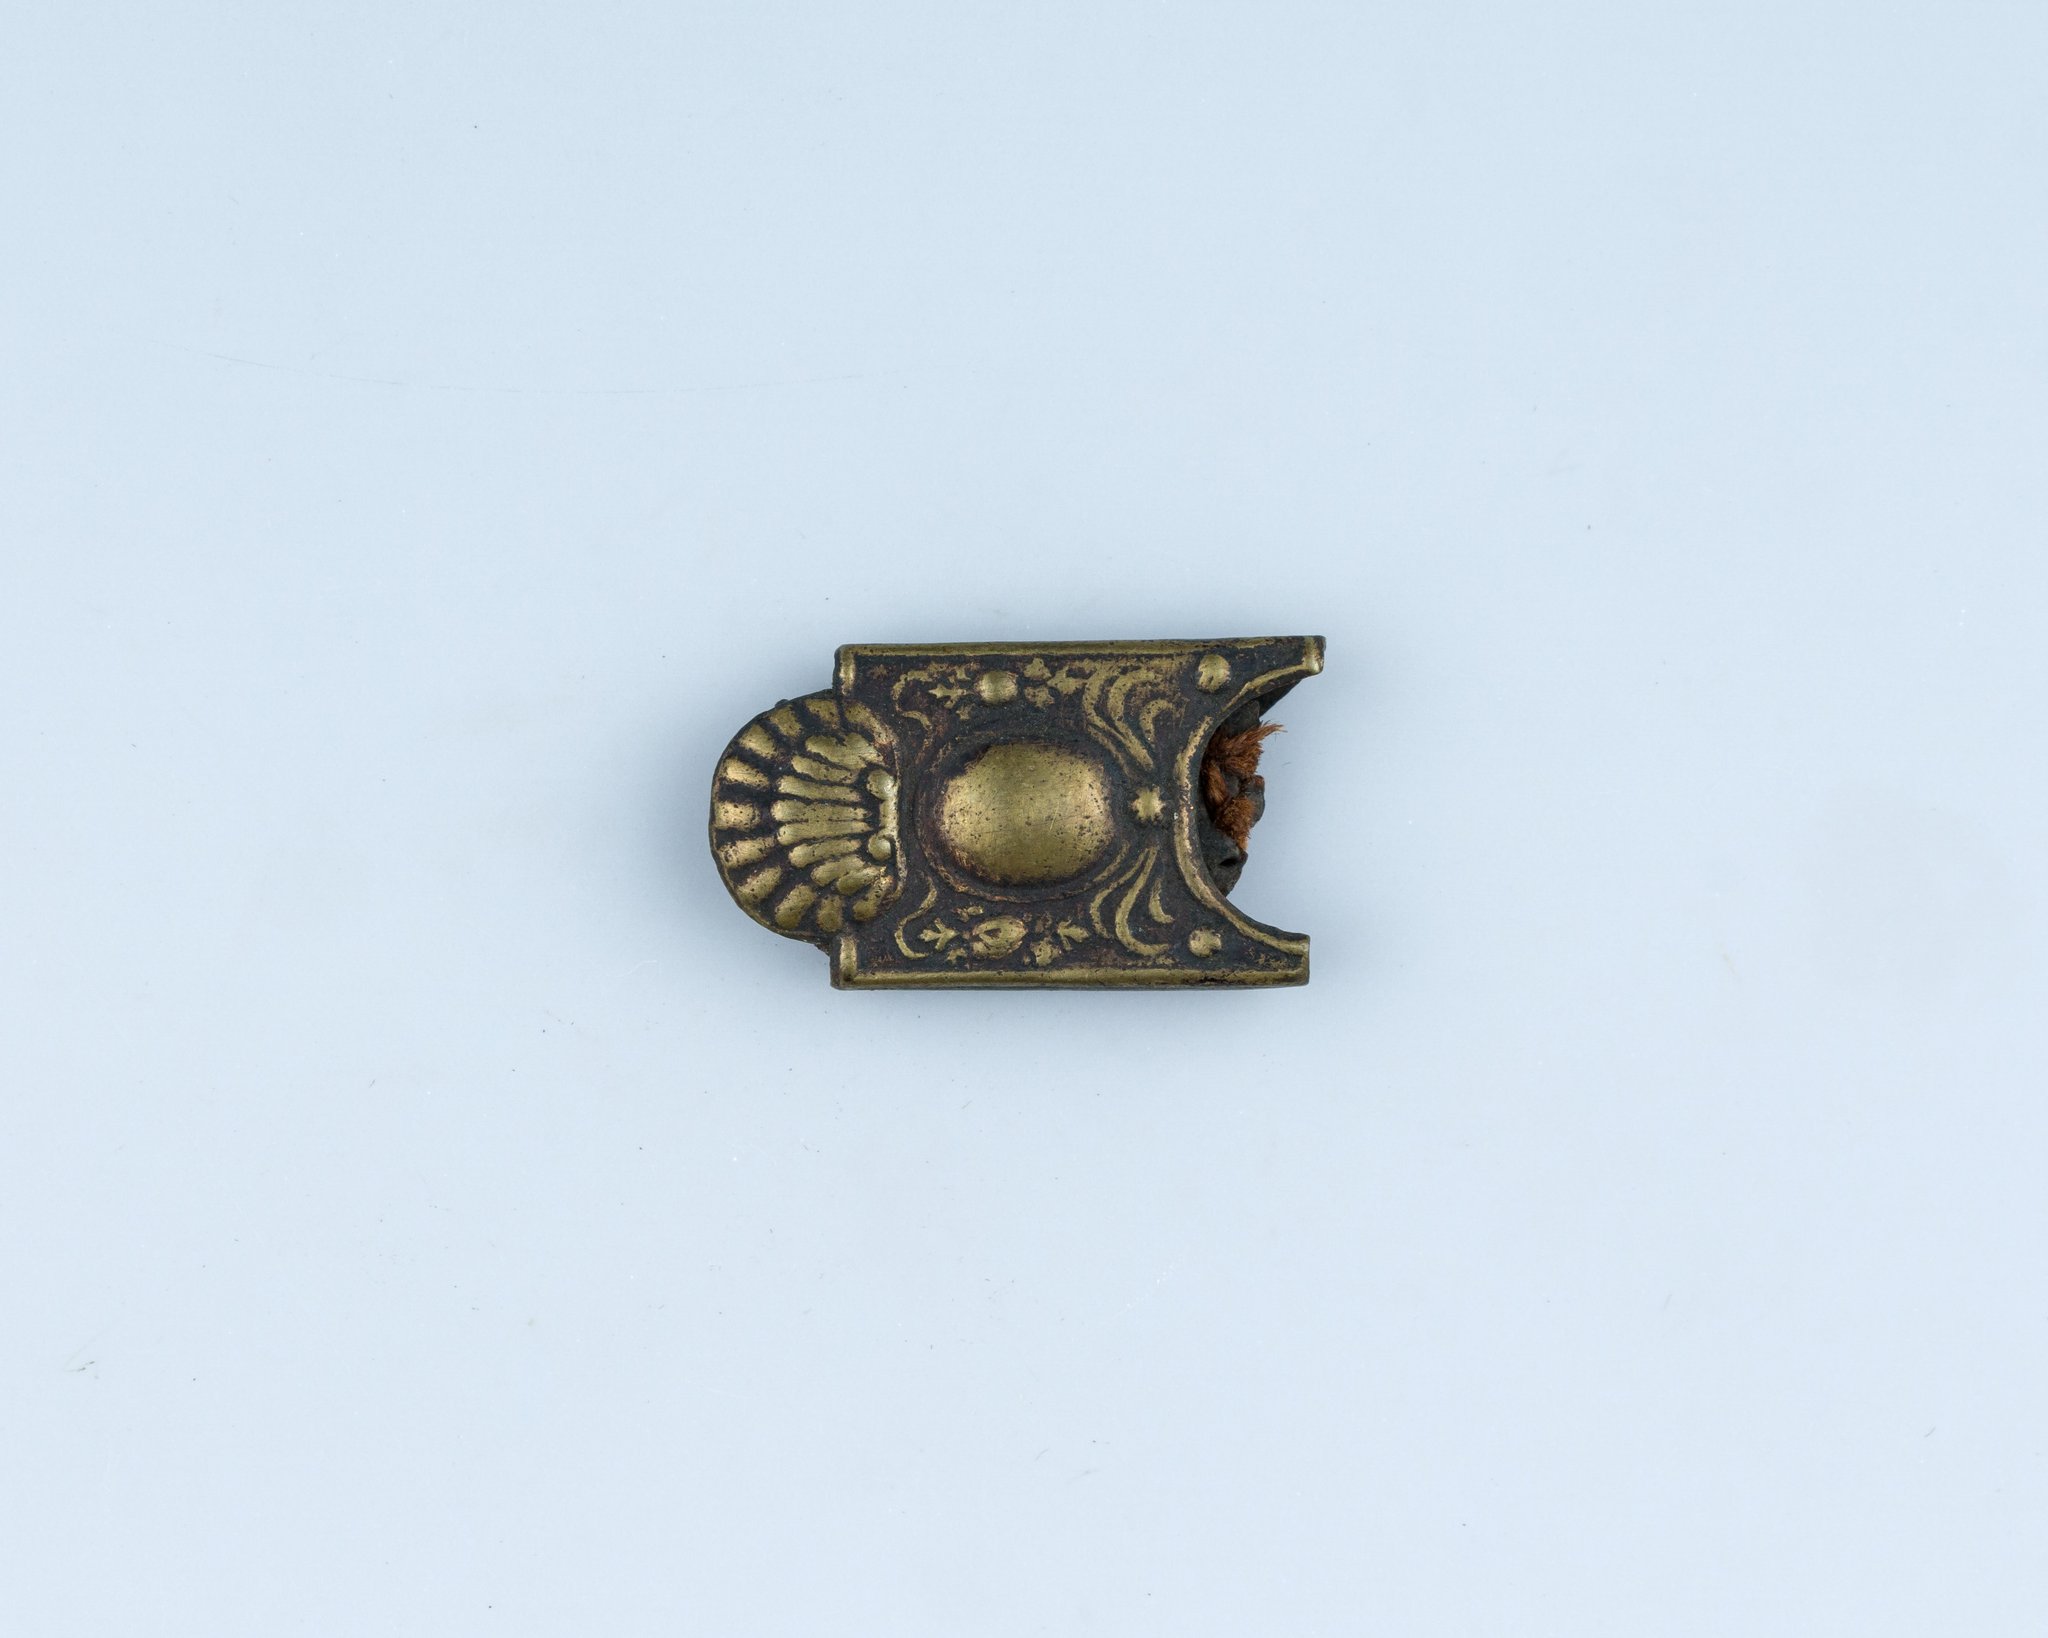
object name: clamp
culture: european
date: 1401-1700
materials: brass